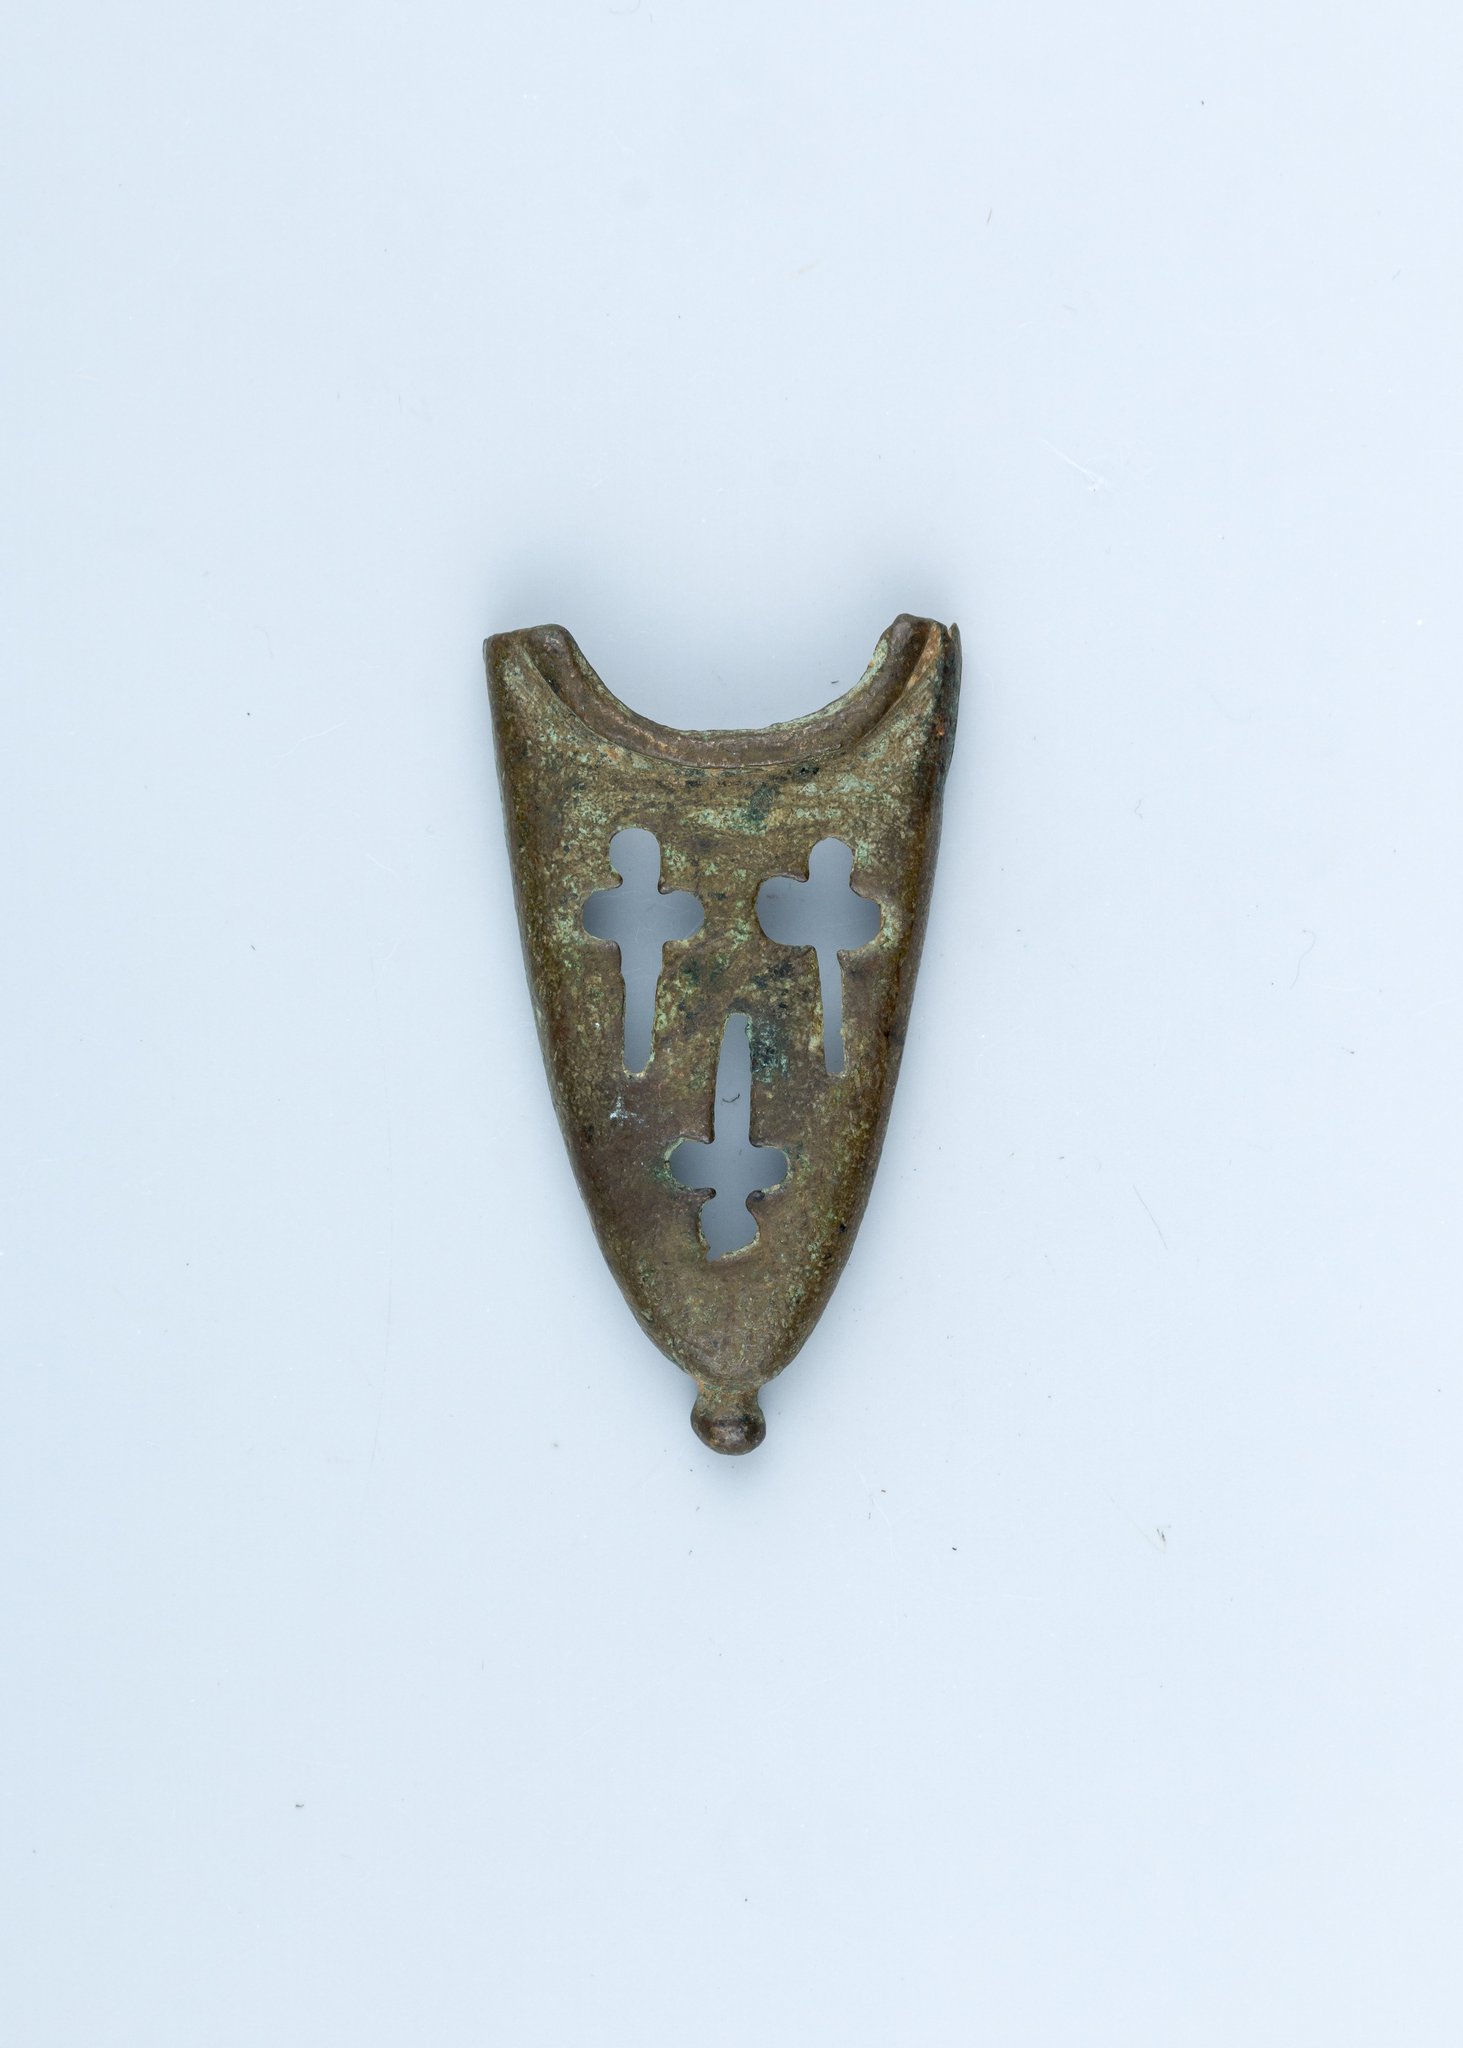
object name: pendant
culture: european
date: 1401-1700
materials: bronze